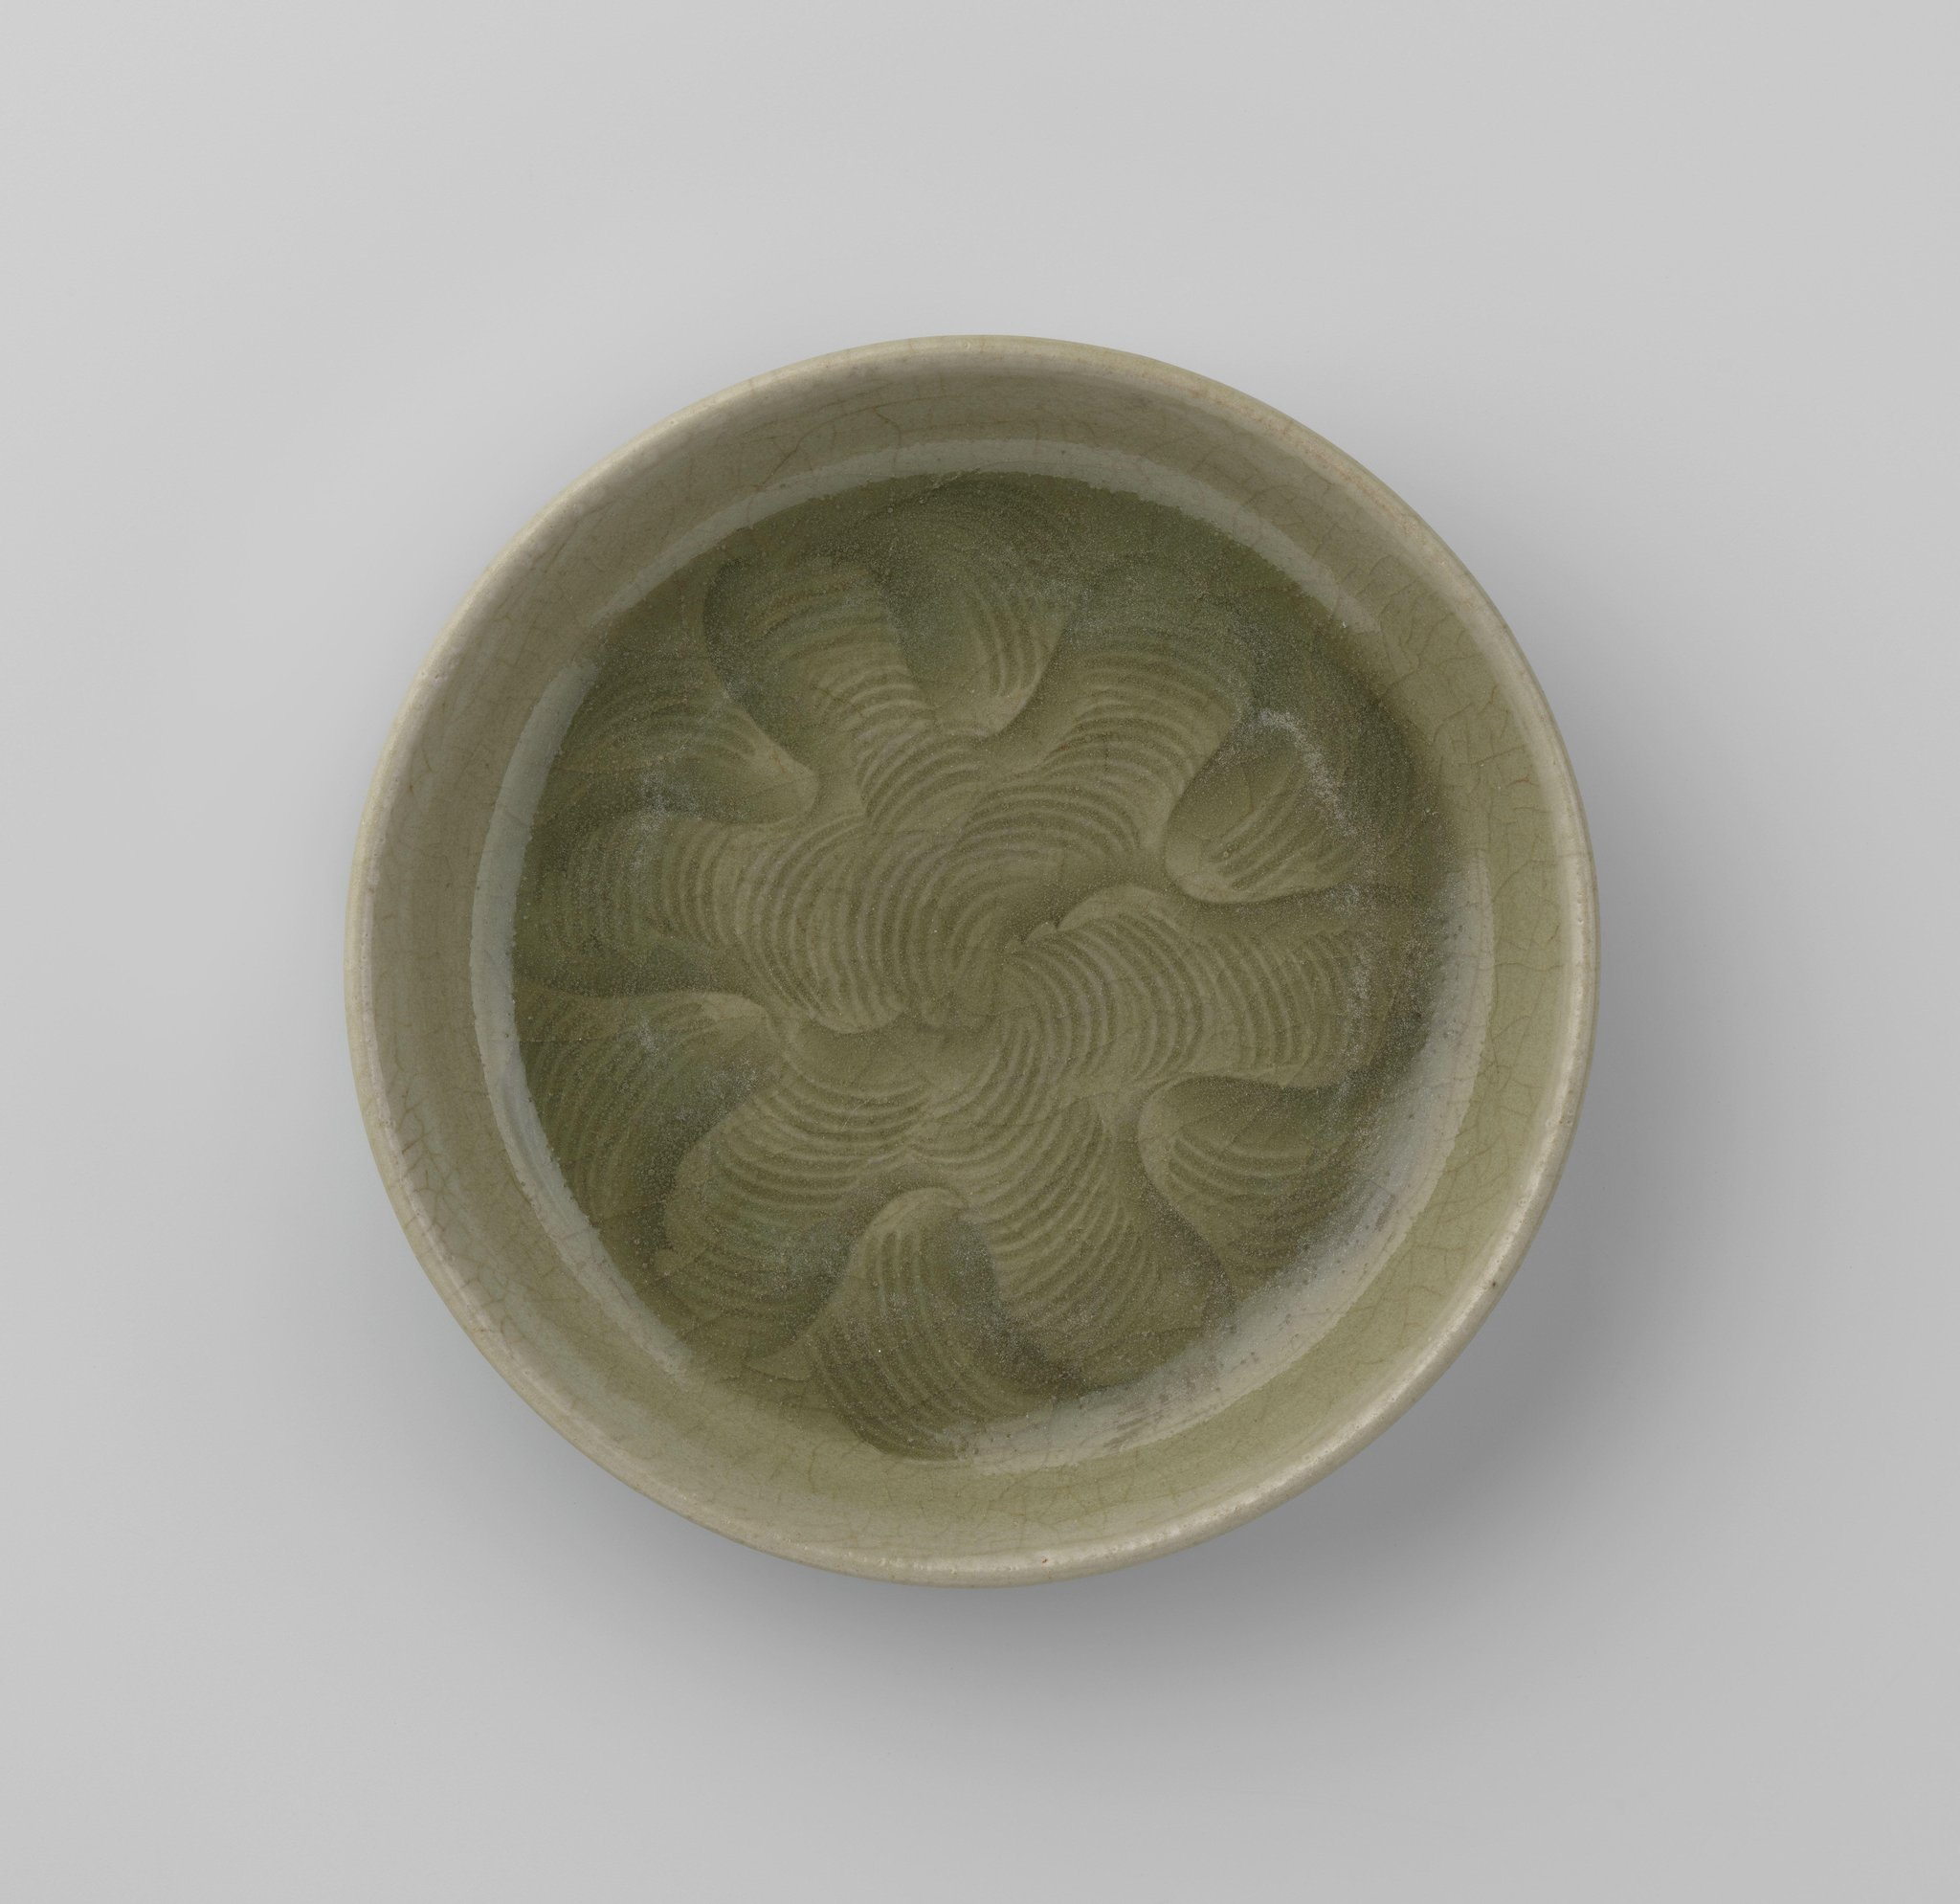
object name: platter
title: Dish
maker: Anonymous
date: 1000-1199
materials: ceramic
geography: china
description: This stoneware dish is decorated with a wave motif created by incising and combing the clay. The dish was then provided with a green glaze, called celadon. The depth of the carving determines the range of shades and creates attractive variations in the colour. This kind of olive-green glaze is typical of stoneware from Yaozhou kilns in Shaanxi Province.